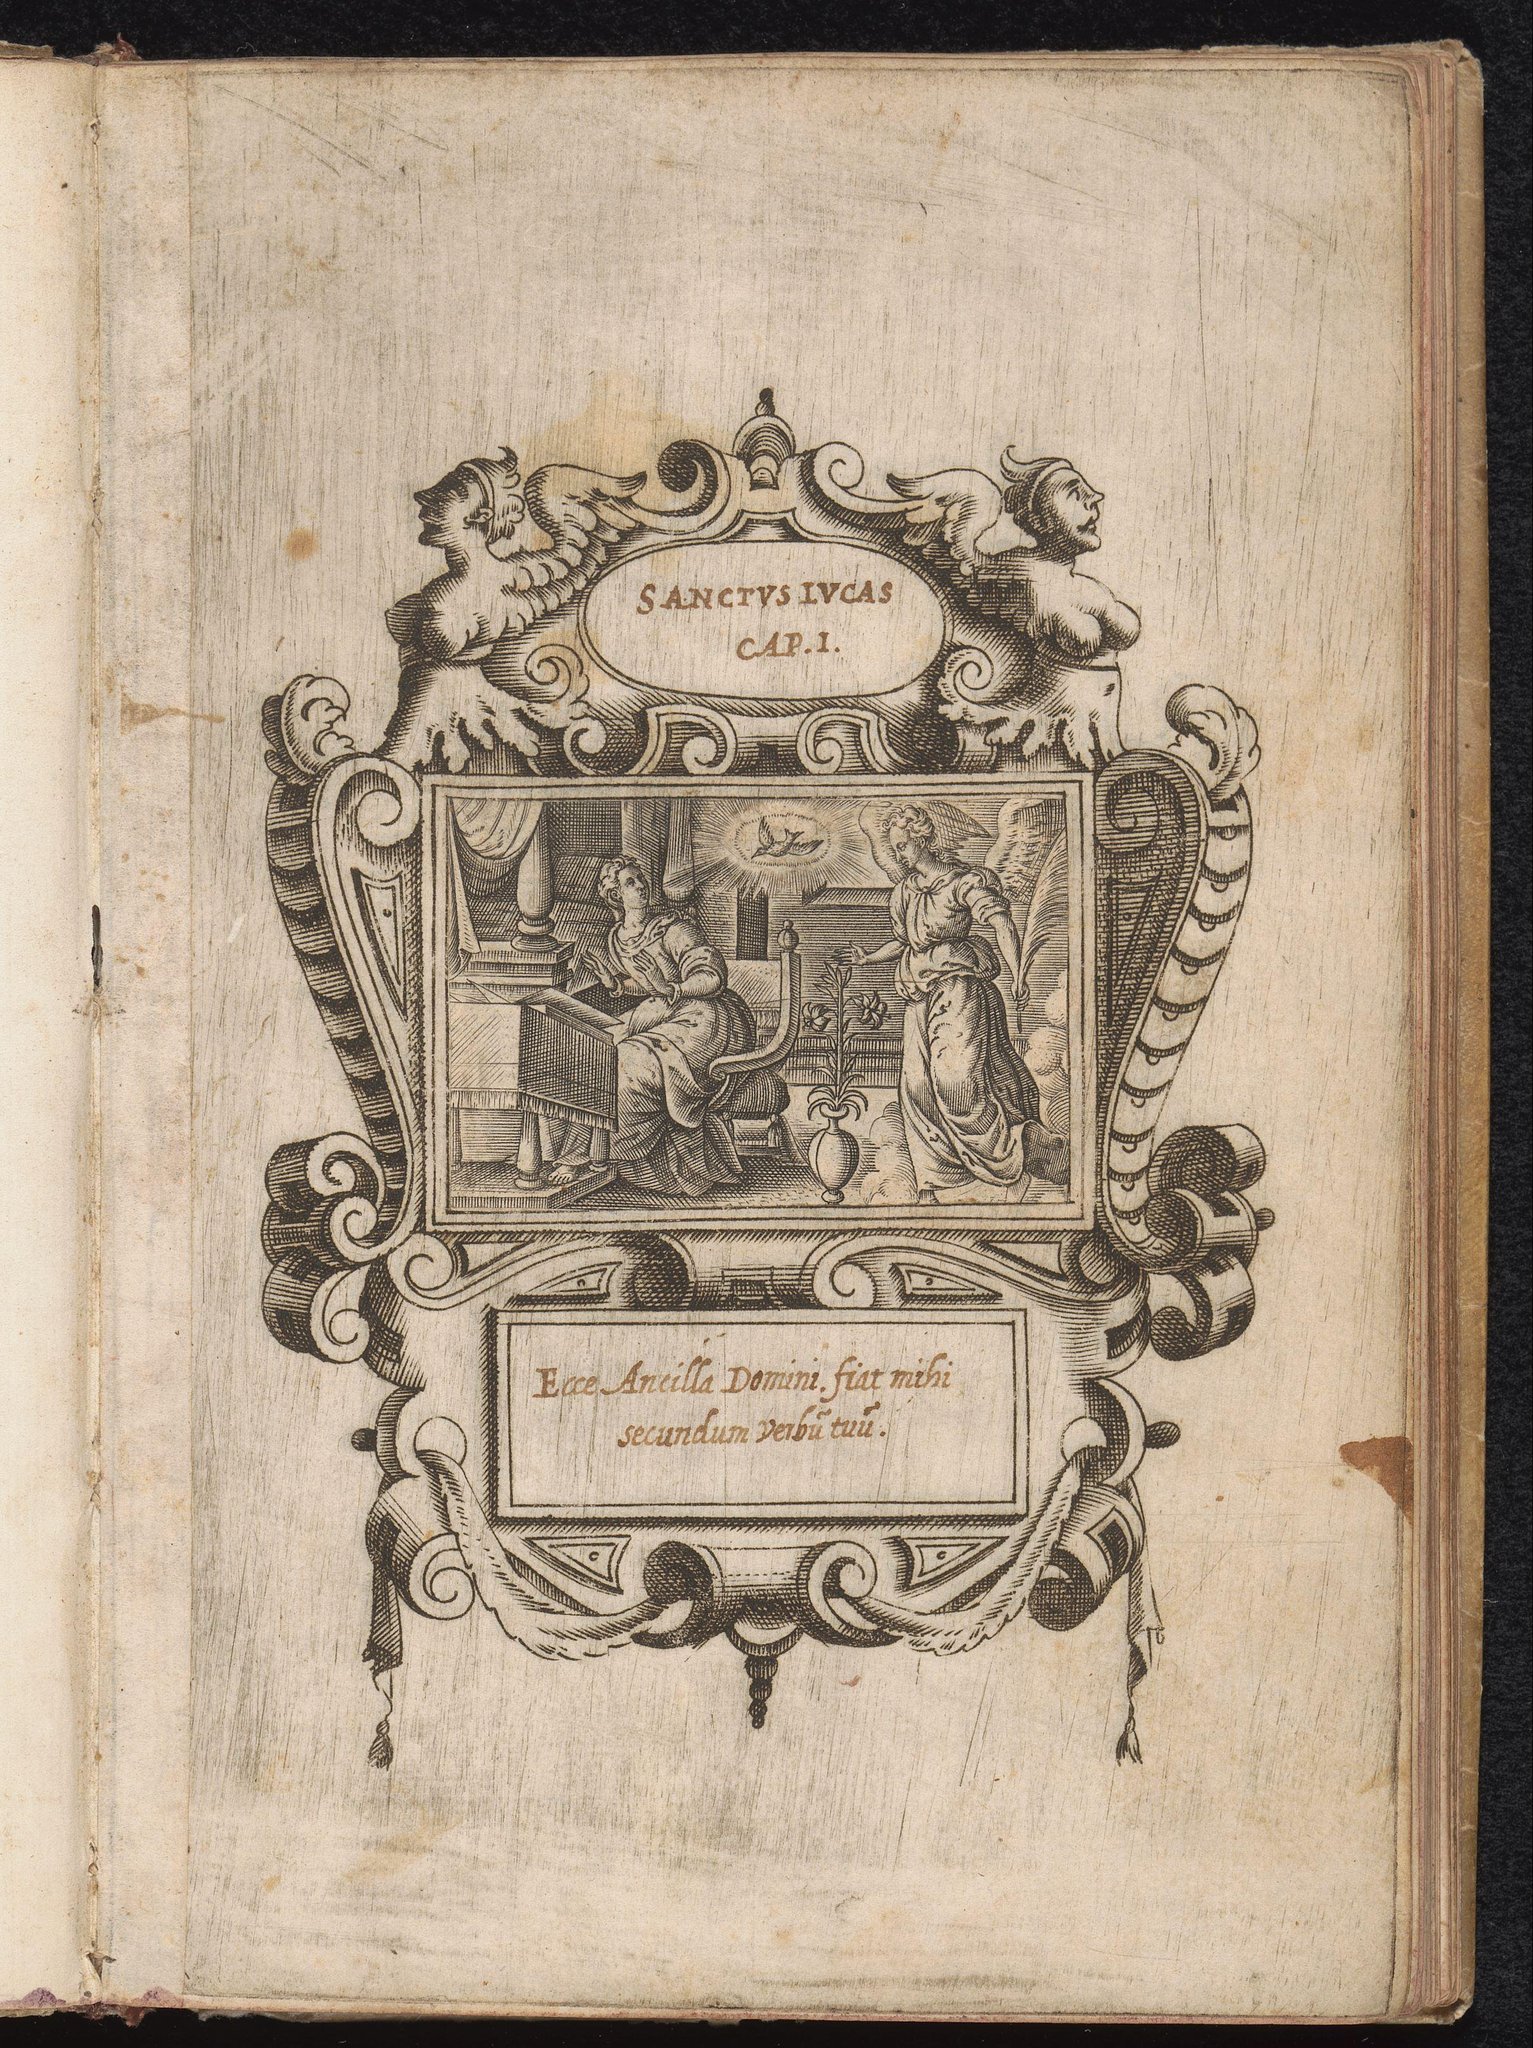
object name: print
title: Het leven van Christus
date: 1570-1610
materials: paper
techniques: engraving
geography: antwerp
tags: the annunciation: mary sitting - aa - mary to the left, the angel to the right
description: De verkondiging aan Maria. Onderdeel van een prentalbum met titelprent en 56 scènes uit het Nieuwe Testament. Elke voorstelling gemonteerd in een gravure met ornamentele cartouches waarin een venster is gesneden en voorzien van handgeschreven bijbelpassages.